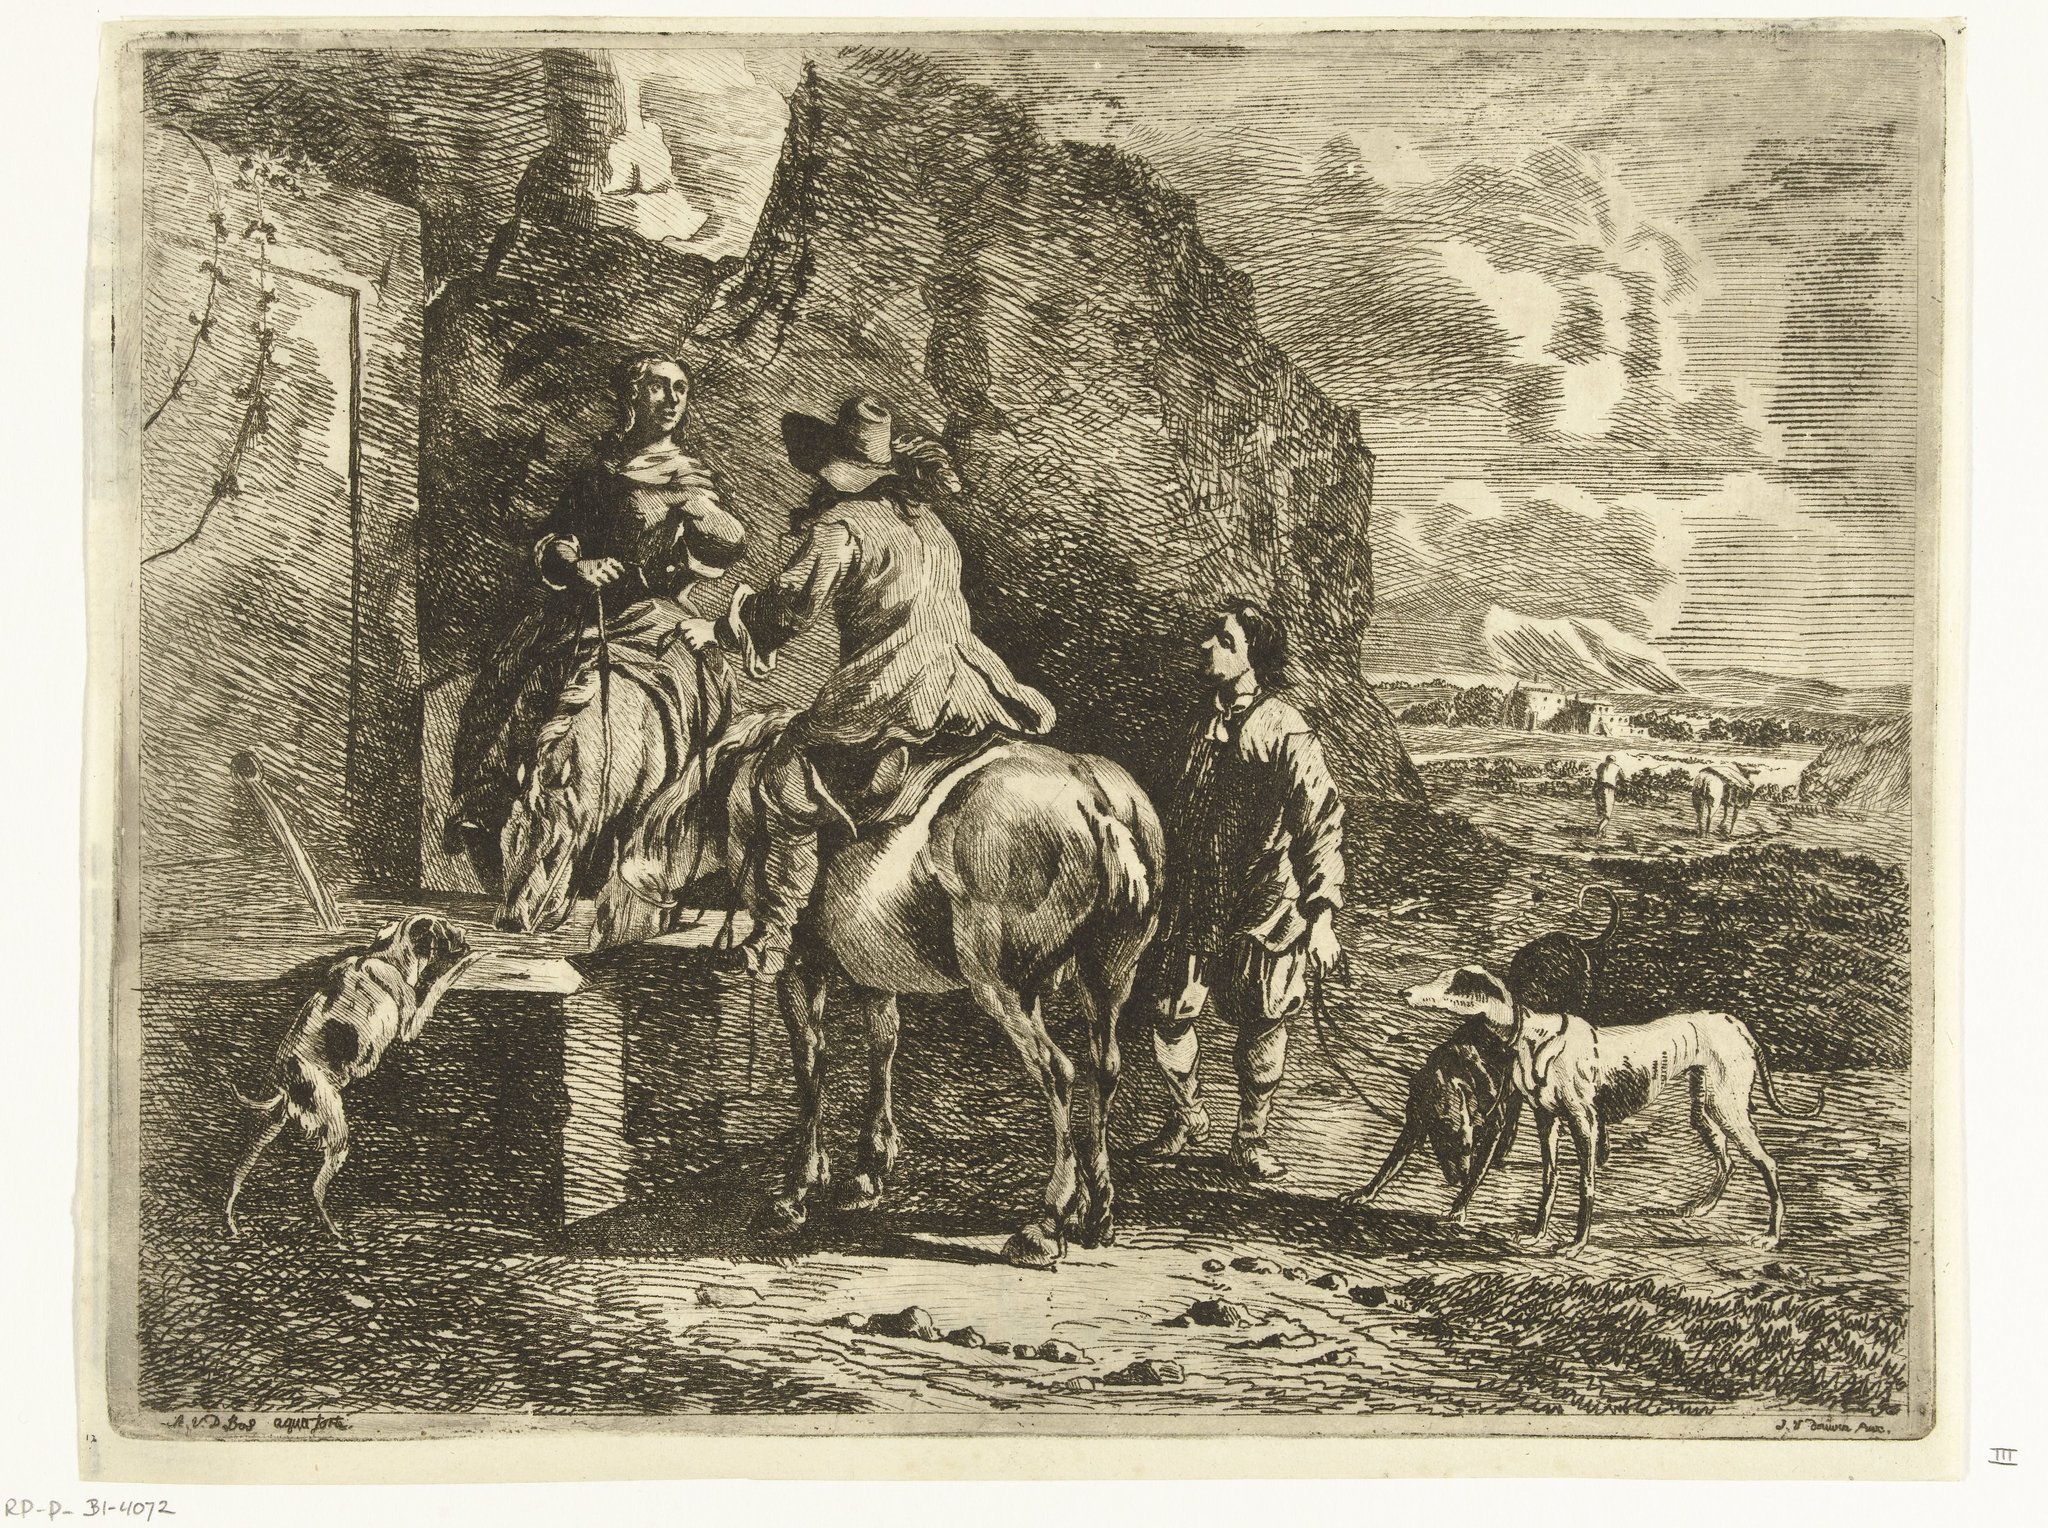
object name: print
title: Ruiters bij drinkplaats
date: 1778-1838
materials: paper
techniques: drypoint, etching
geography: netherlands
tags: man and animal (+ watering animal)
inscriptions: collector's mark: Lugt 2228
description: Een man en een vrouw laten hun paarden drinken bij een fontein in een rotsmuur. Ze maken een praatje met een man die zijn honden uitlaat.